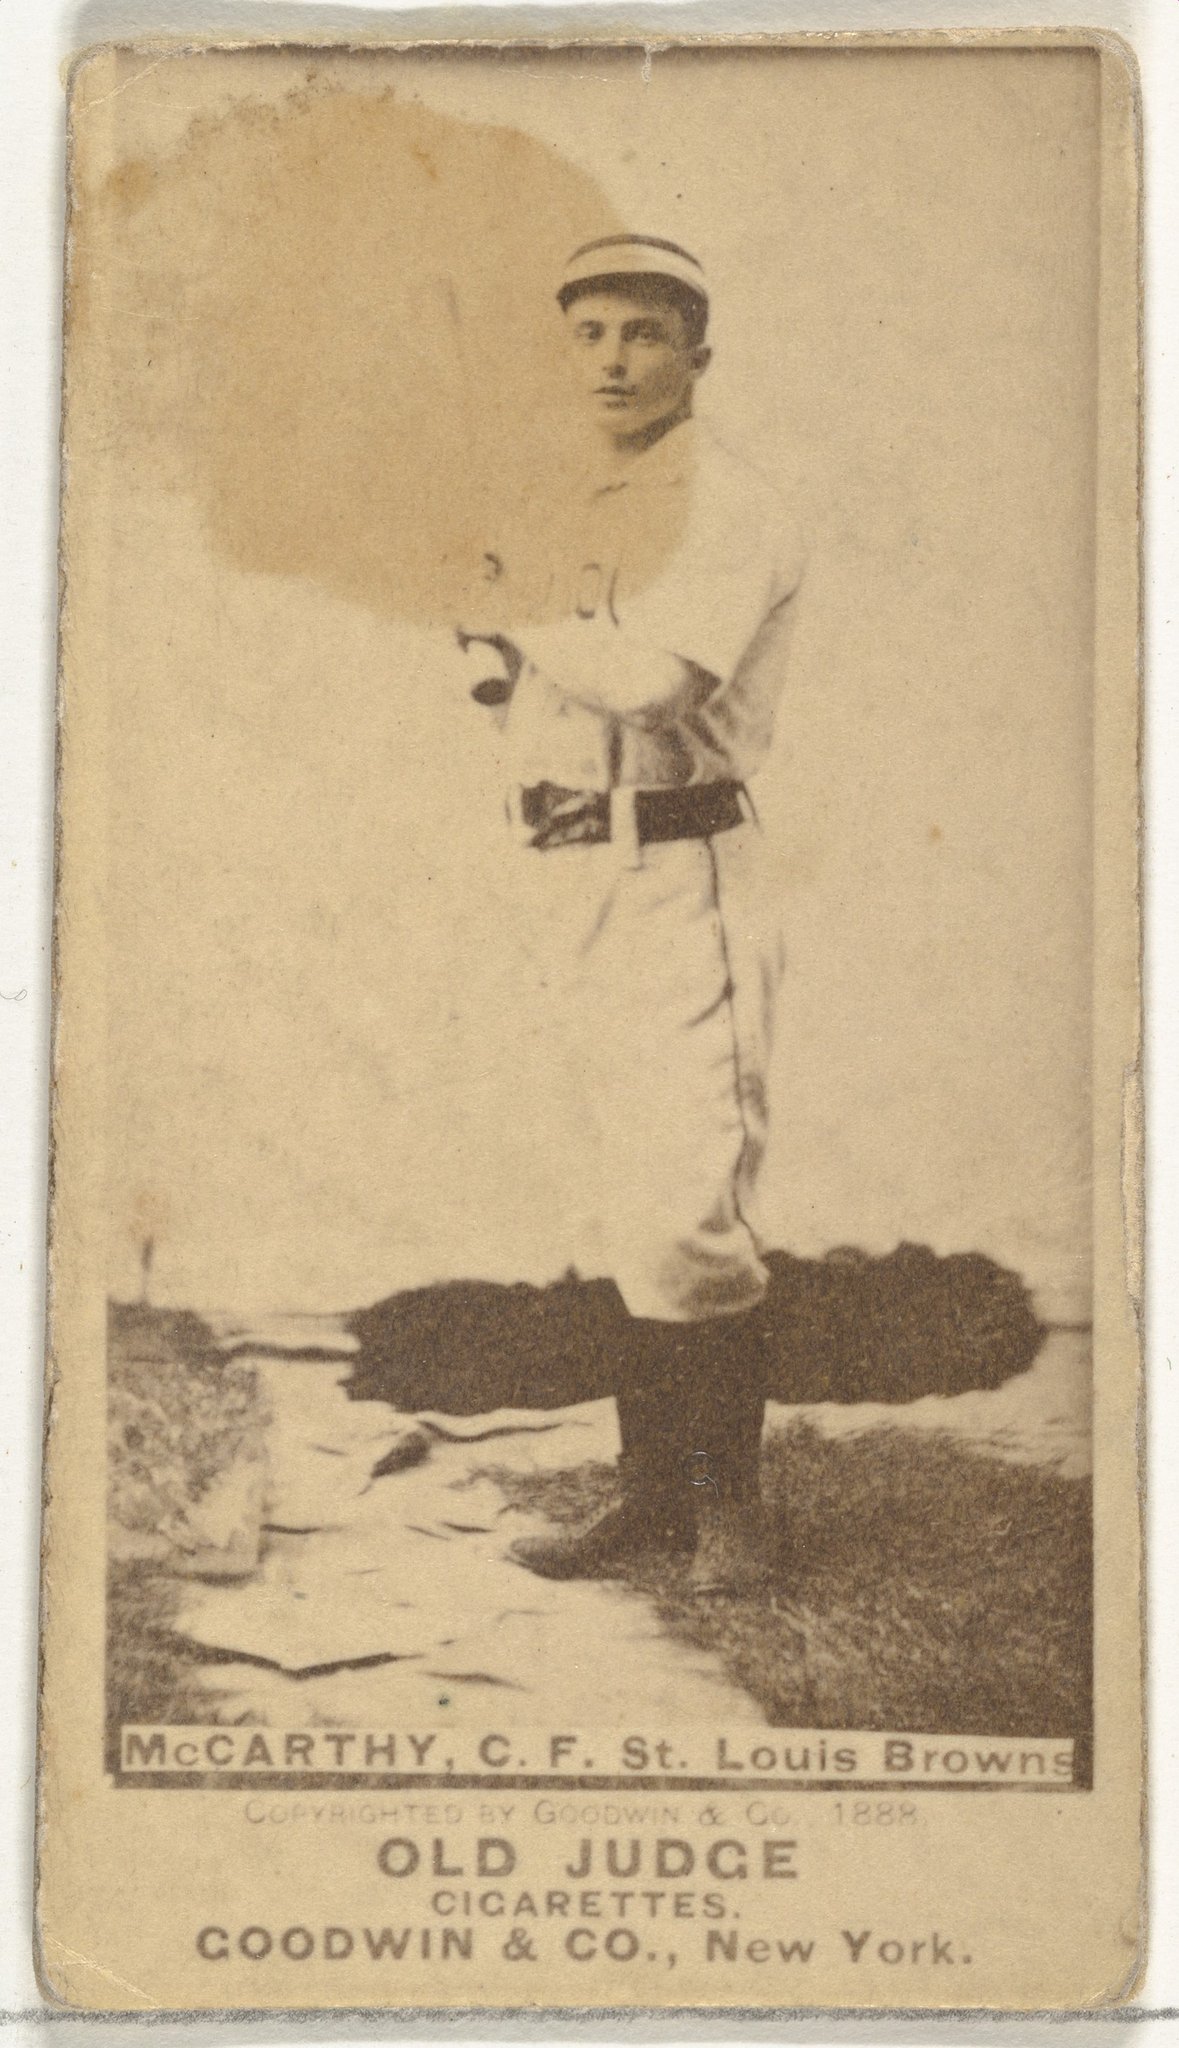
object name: baseball card, photograph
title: Tommy McCarthy, Center Field, St. Louis Browns, from the Old Judge series (N172) for Old Judge Cigarettes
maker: goodwin & company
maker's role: publisher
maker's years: 1850-1950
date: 1888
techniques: albumen silver print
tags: men,portraits,baseball,athletes